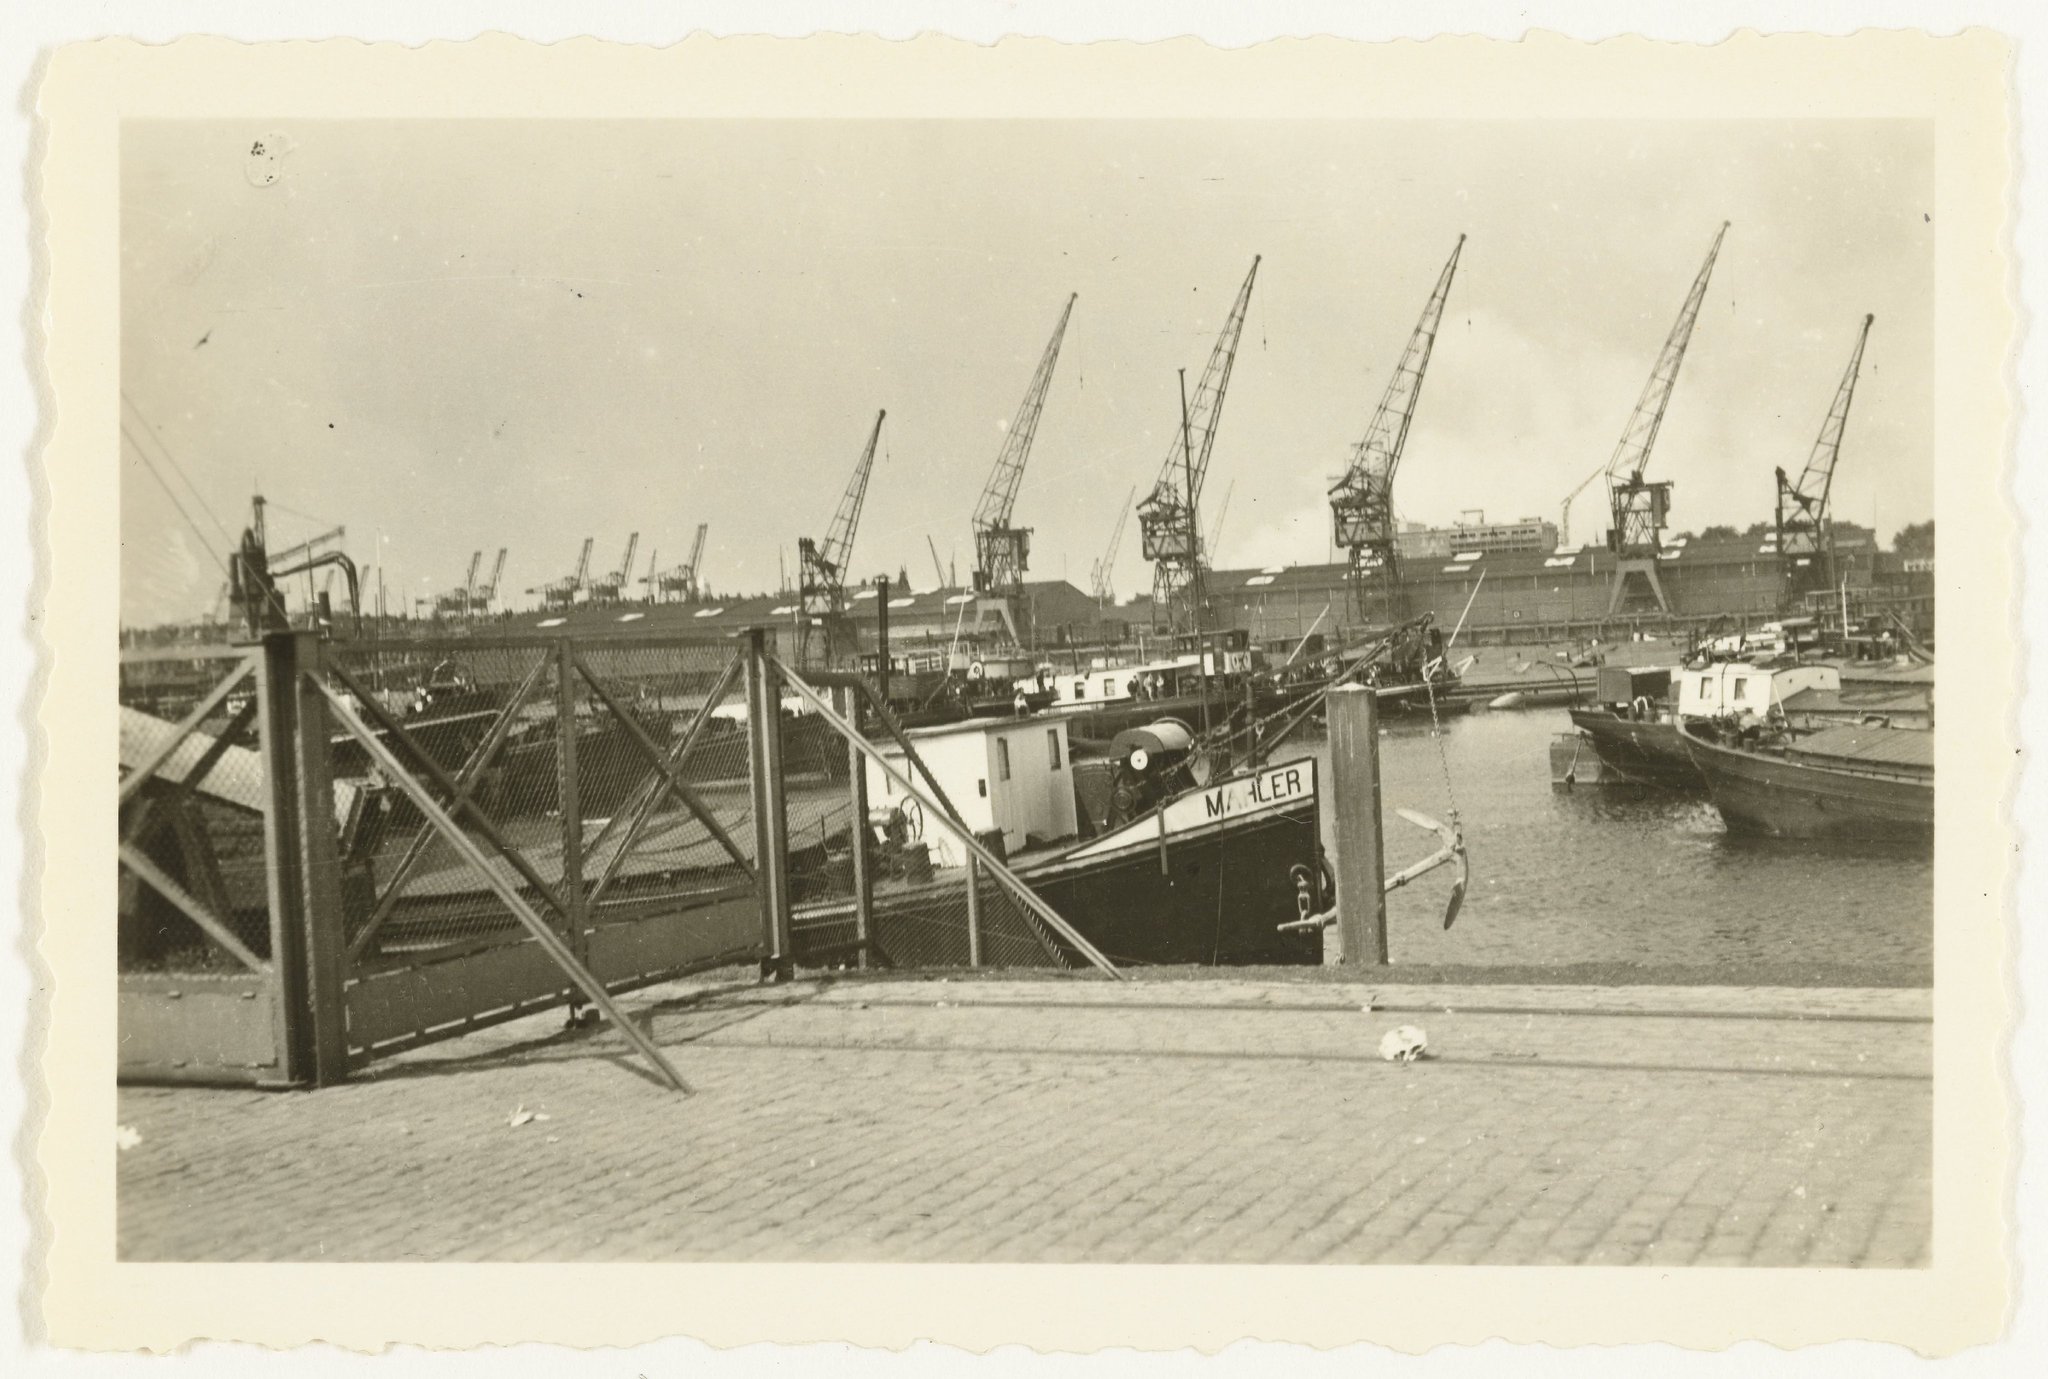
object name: photograph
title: Rotterdamse haven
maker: Anonymous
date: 1940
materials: photographic support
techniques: gelatin silver print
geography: rotterdam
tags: harbour, rotterdam, rotterdam blitz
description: De Rotterdamse haven, in de verte een aantal kranen, op de dag van het bombardement. Achterzijde foto: Rotterdam hafen, 14-5-40.